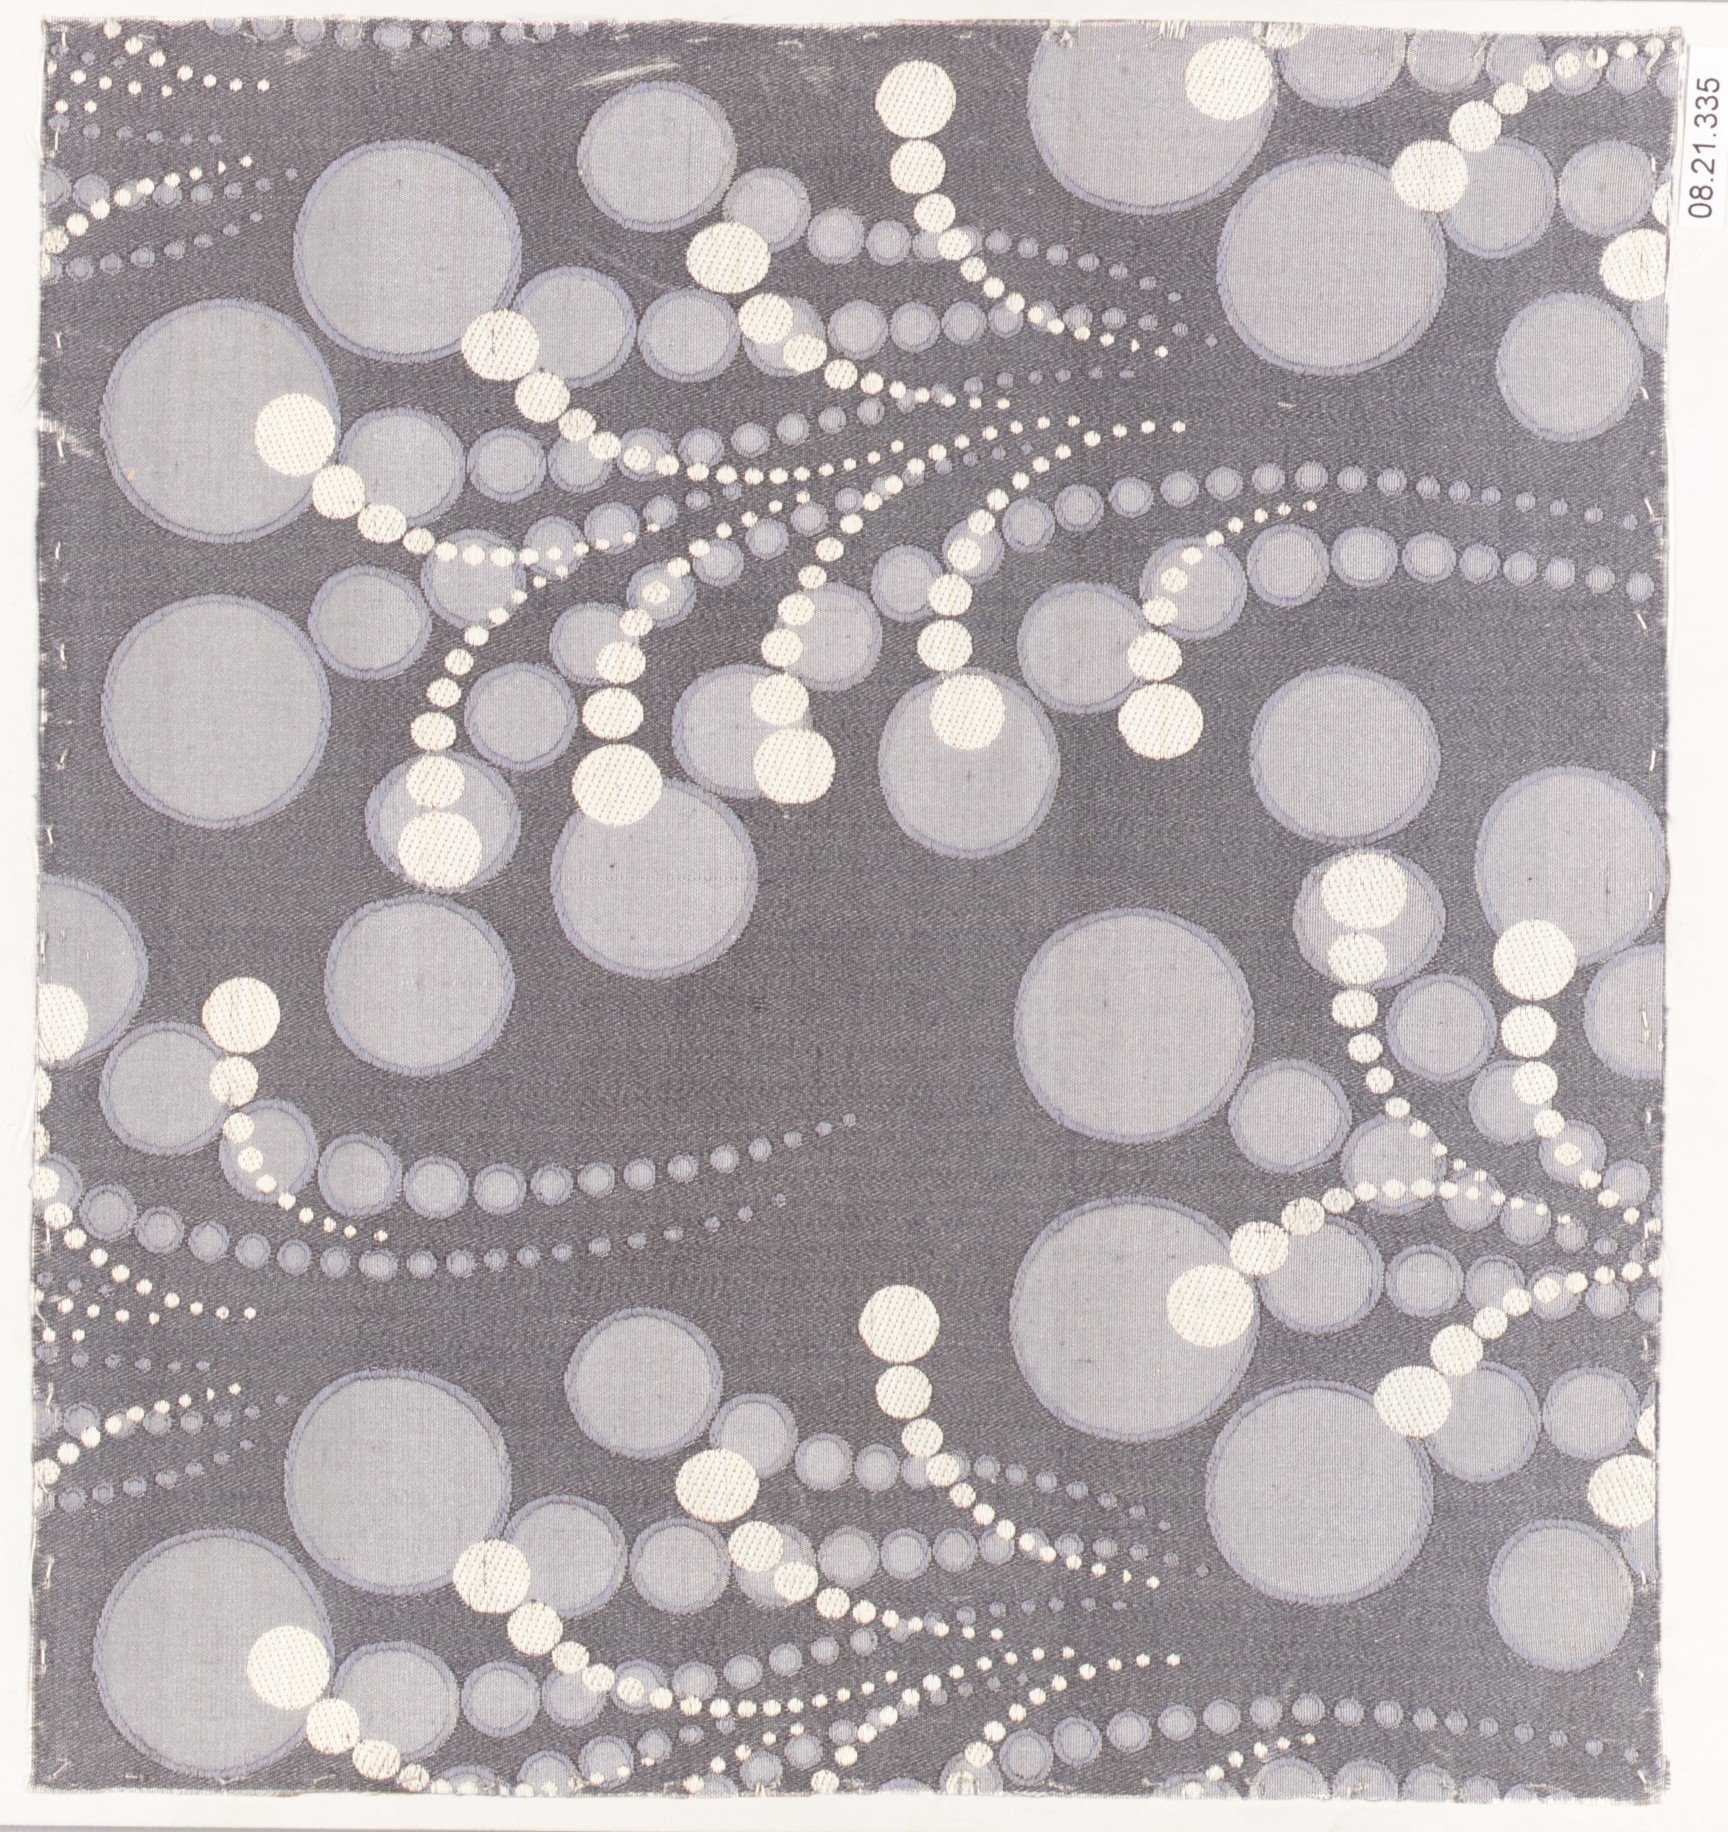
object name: textile sample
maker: Anonymous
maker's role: designer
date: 1900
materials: silk